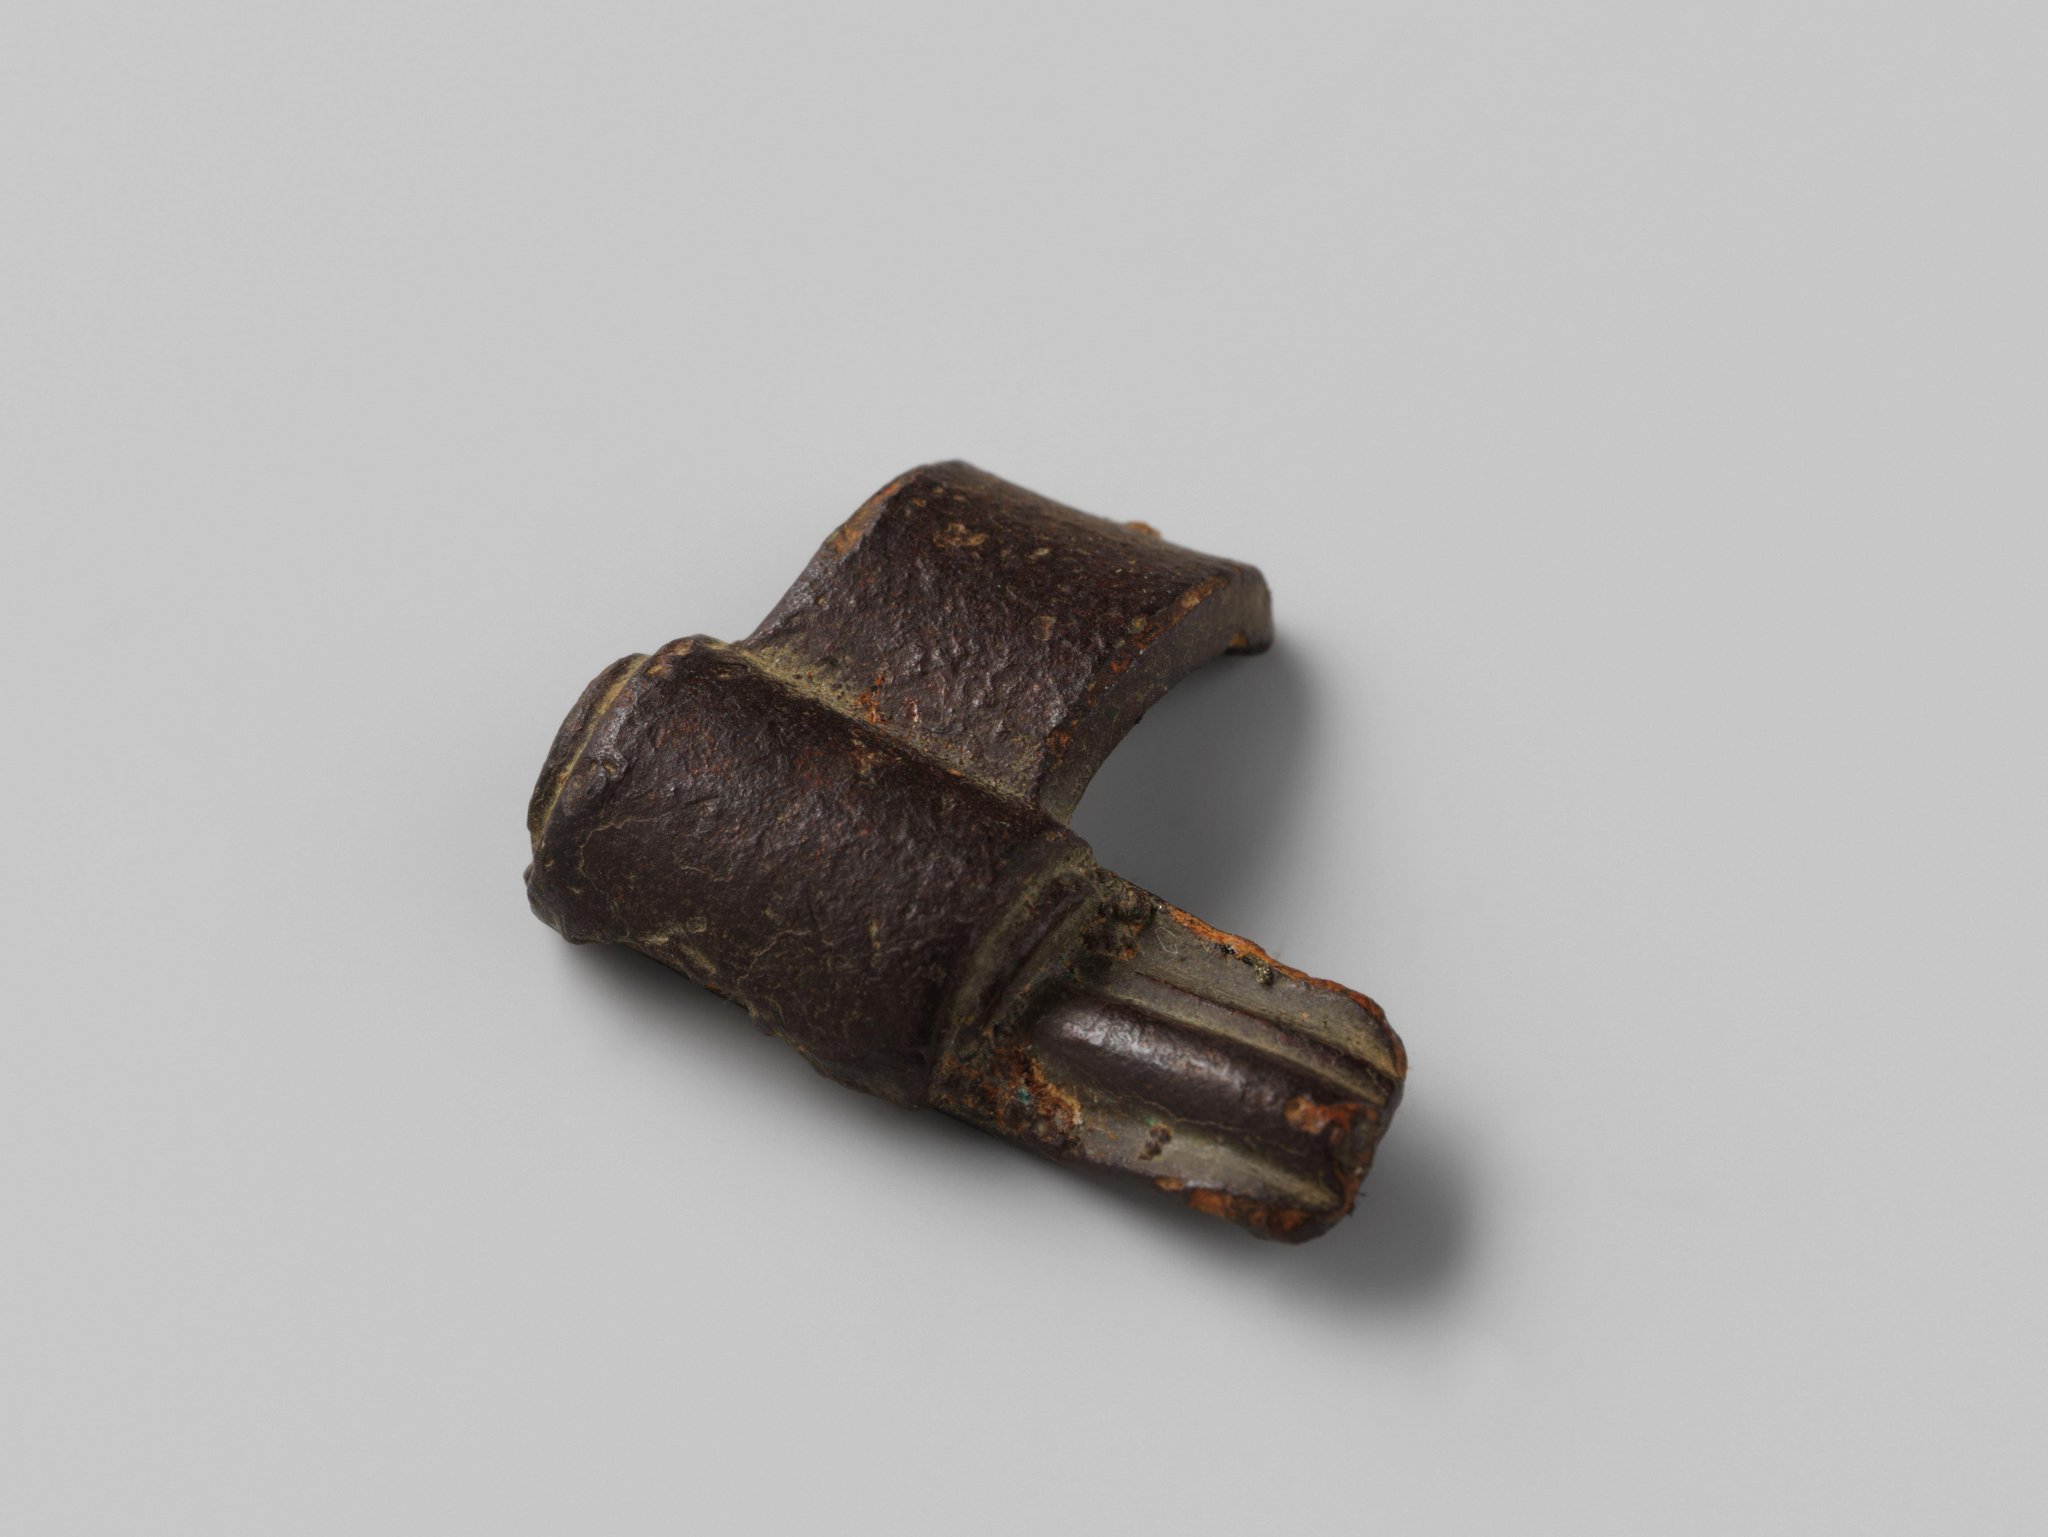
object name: bekroning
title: Bekroning of uiteinde uit het wrak van de Oost-Indiëvaarder Hollandia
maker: Anonymous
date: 1700-1743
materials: copper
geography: netherlands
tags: verenigde oostindische compagnie, hollandia (schip), annet